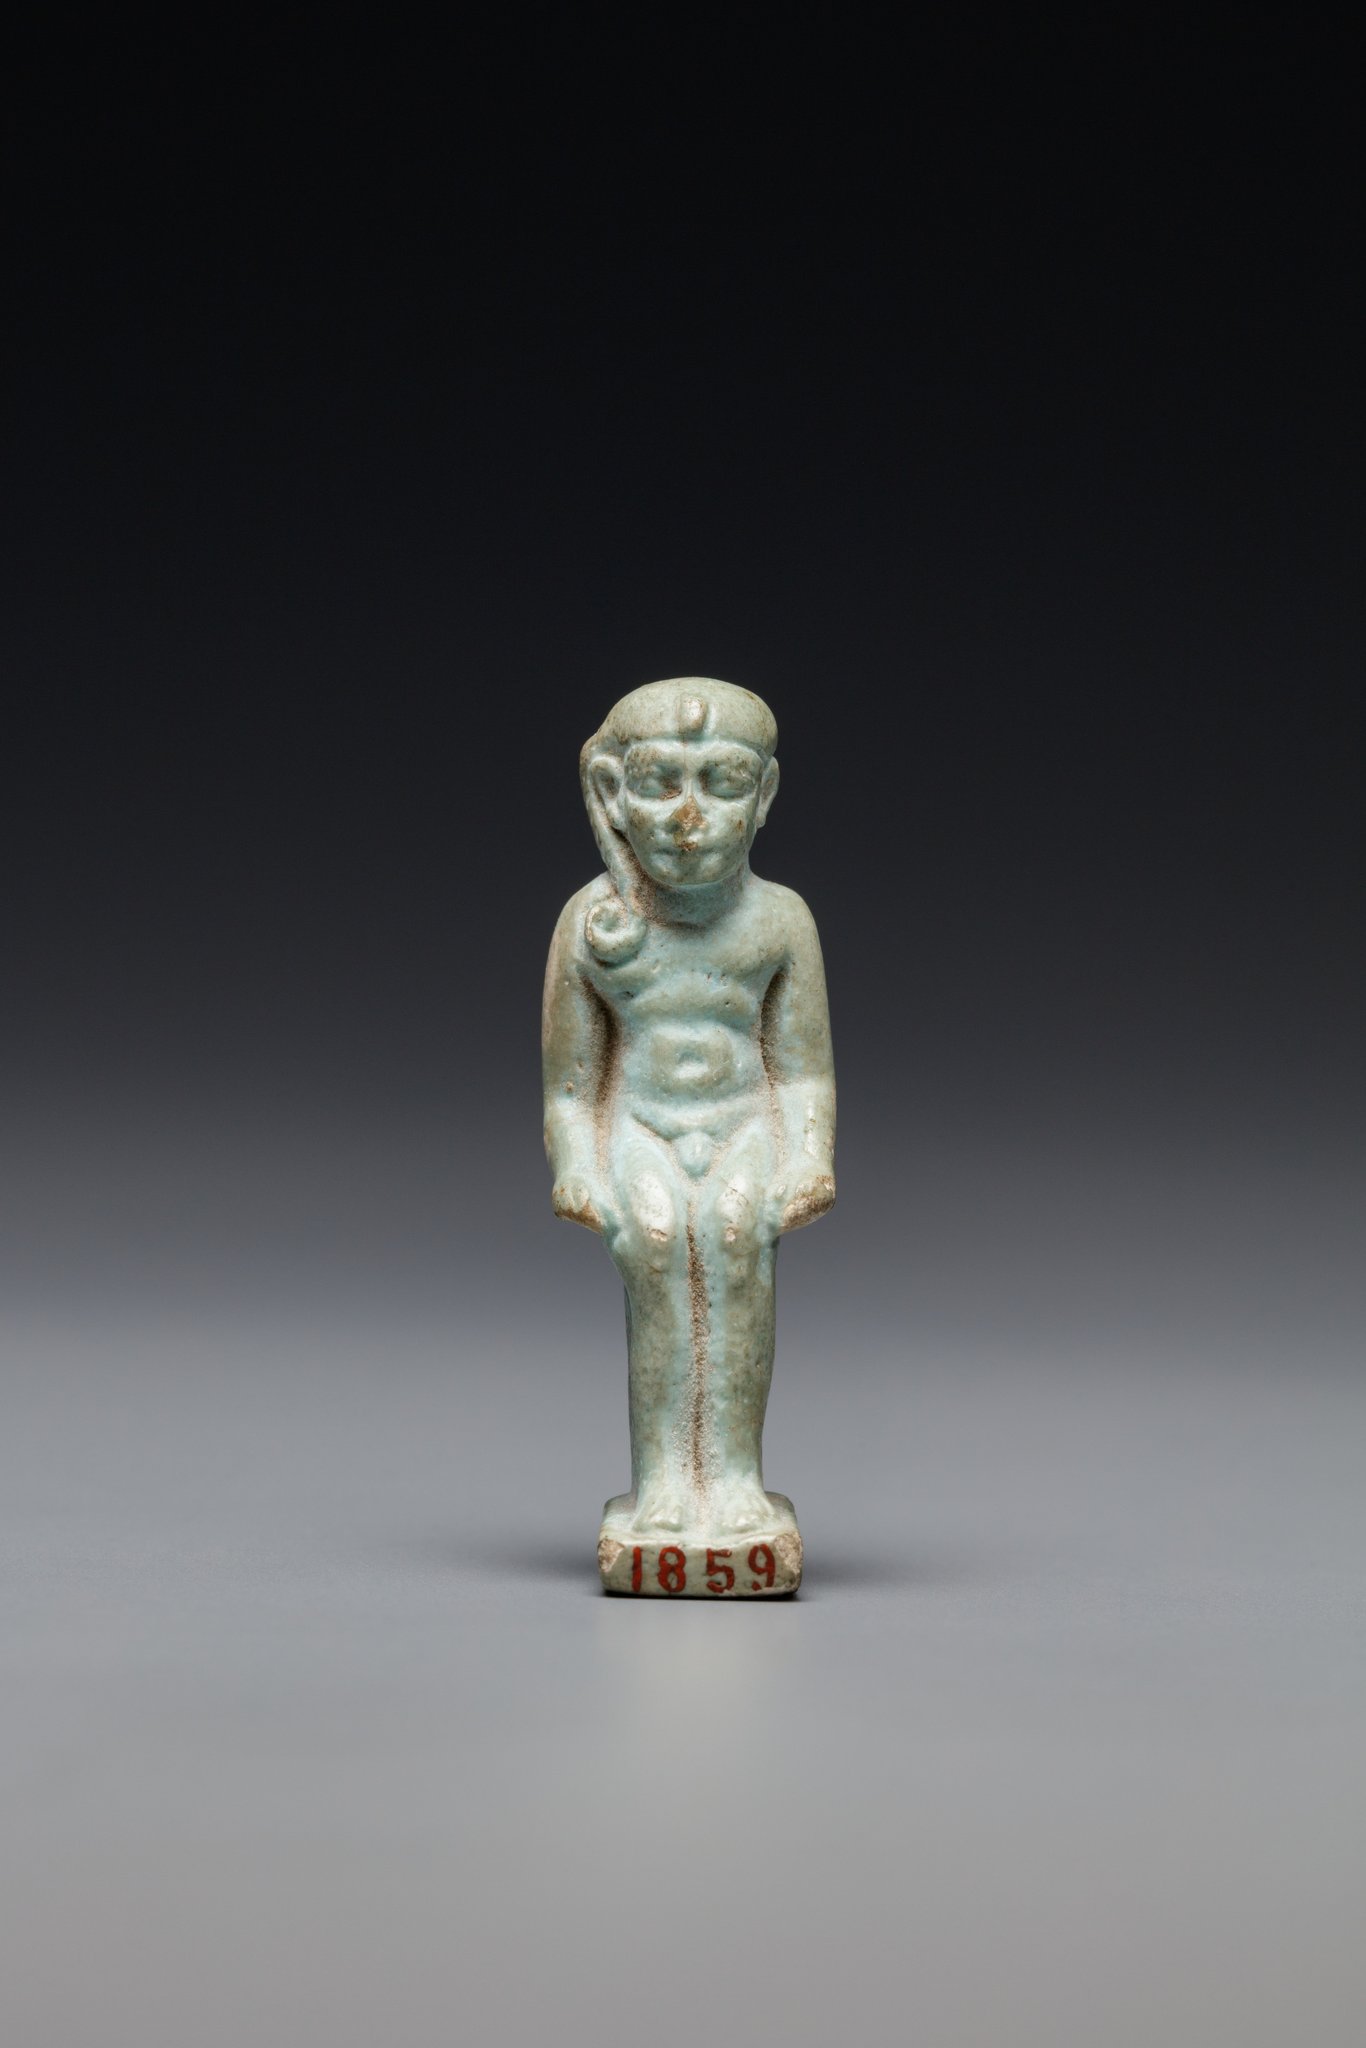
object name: amulet, harpokrates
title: Harpokrates amulet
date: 664-332 BCE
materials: faience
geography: egypt